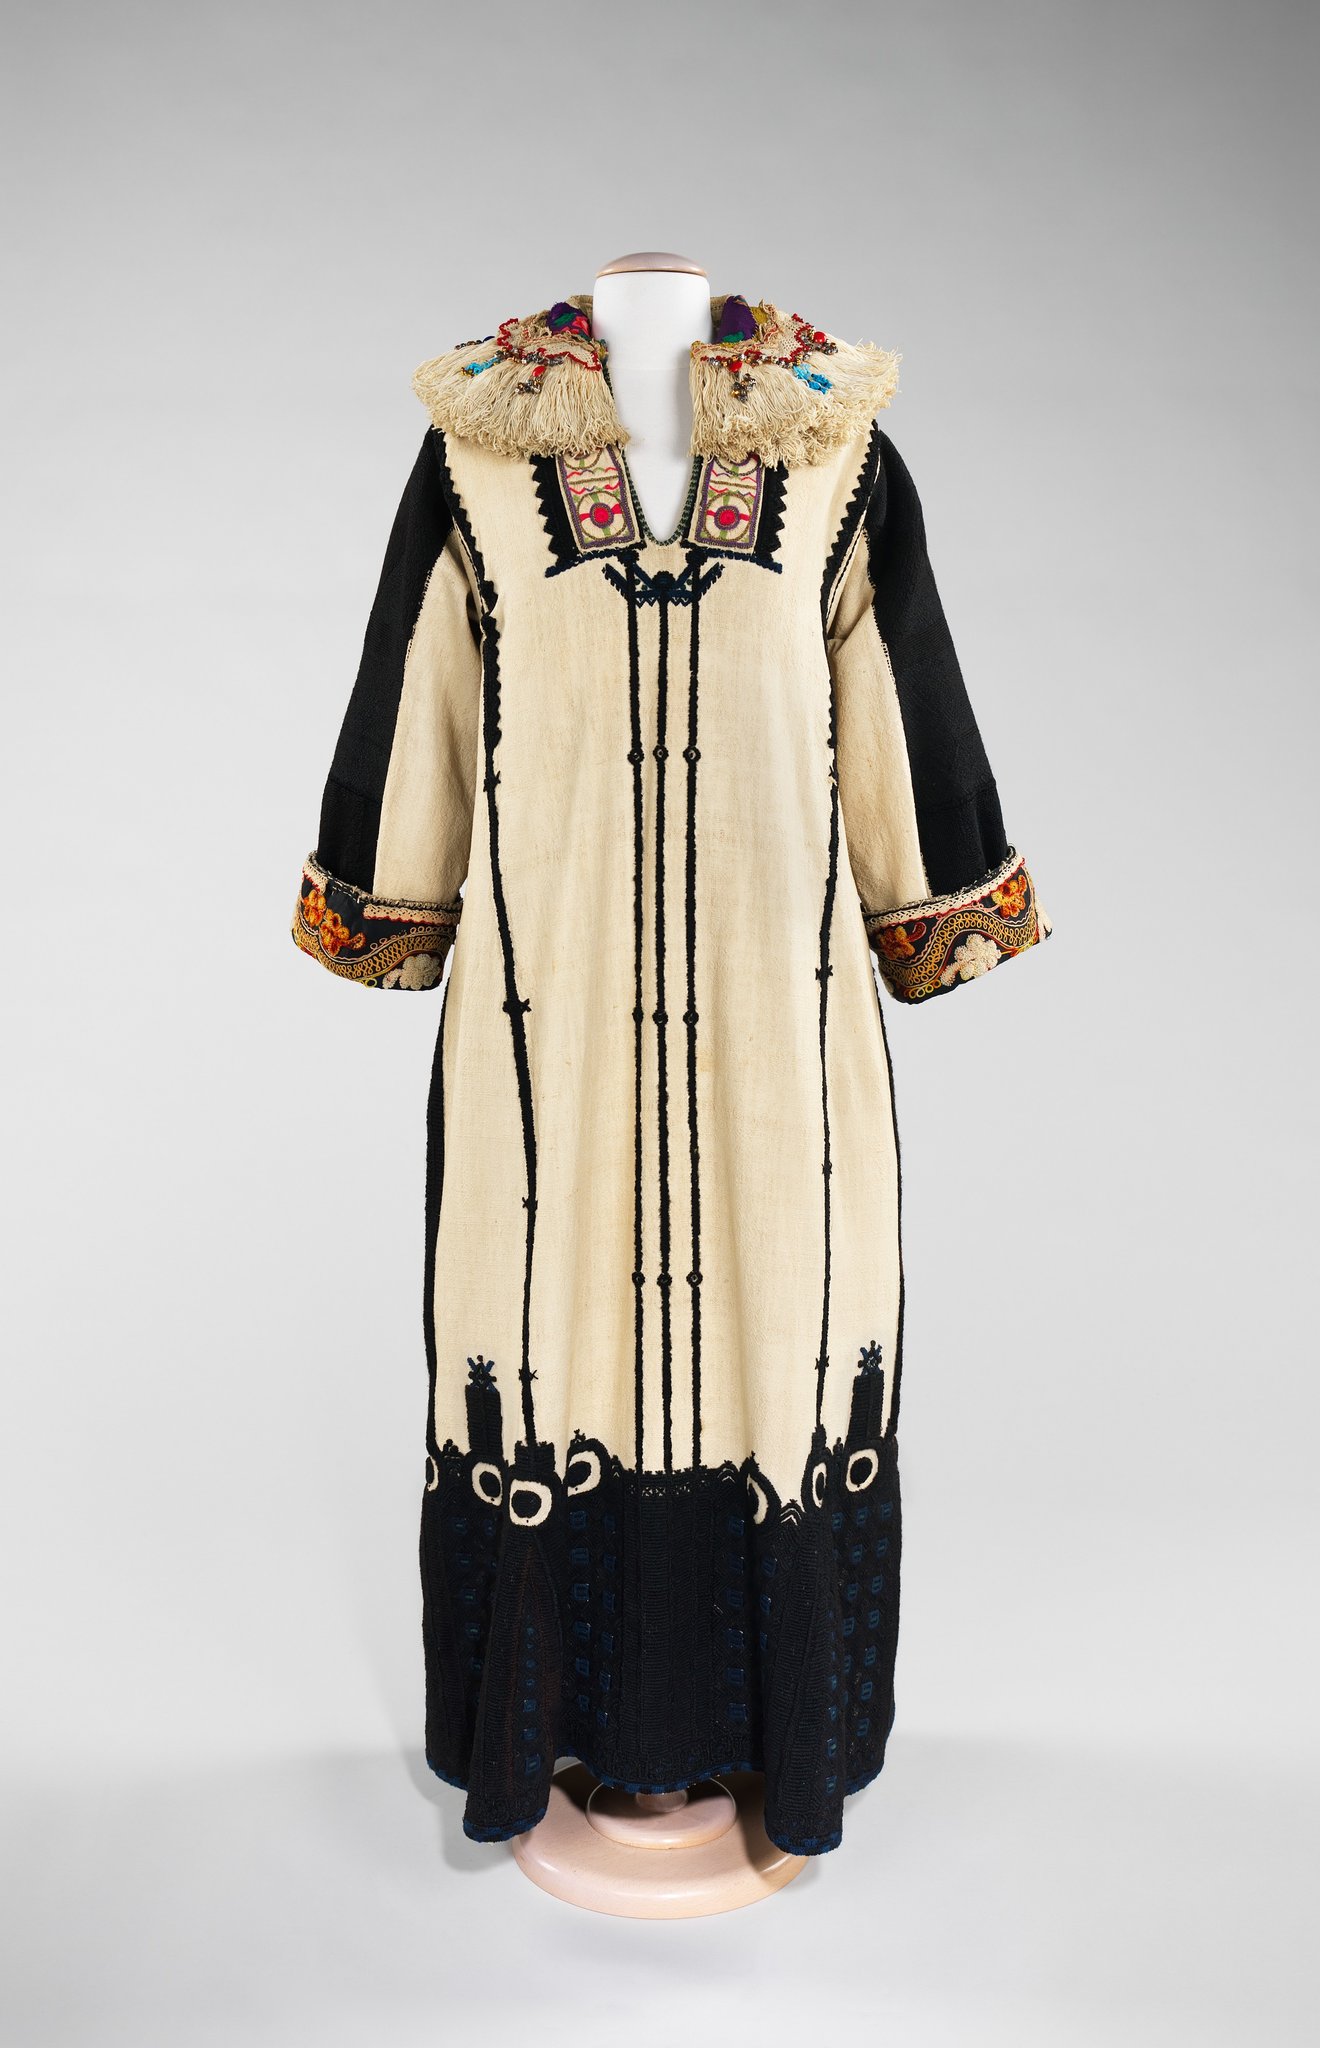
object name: dress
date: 1867-1900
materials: cotton, wool